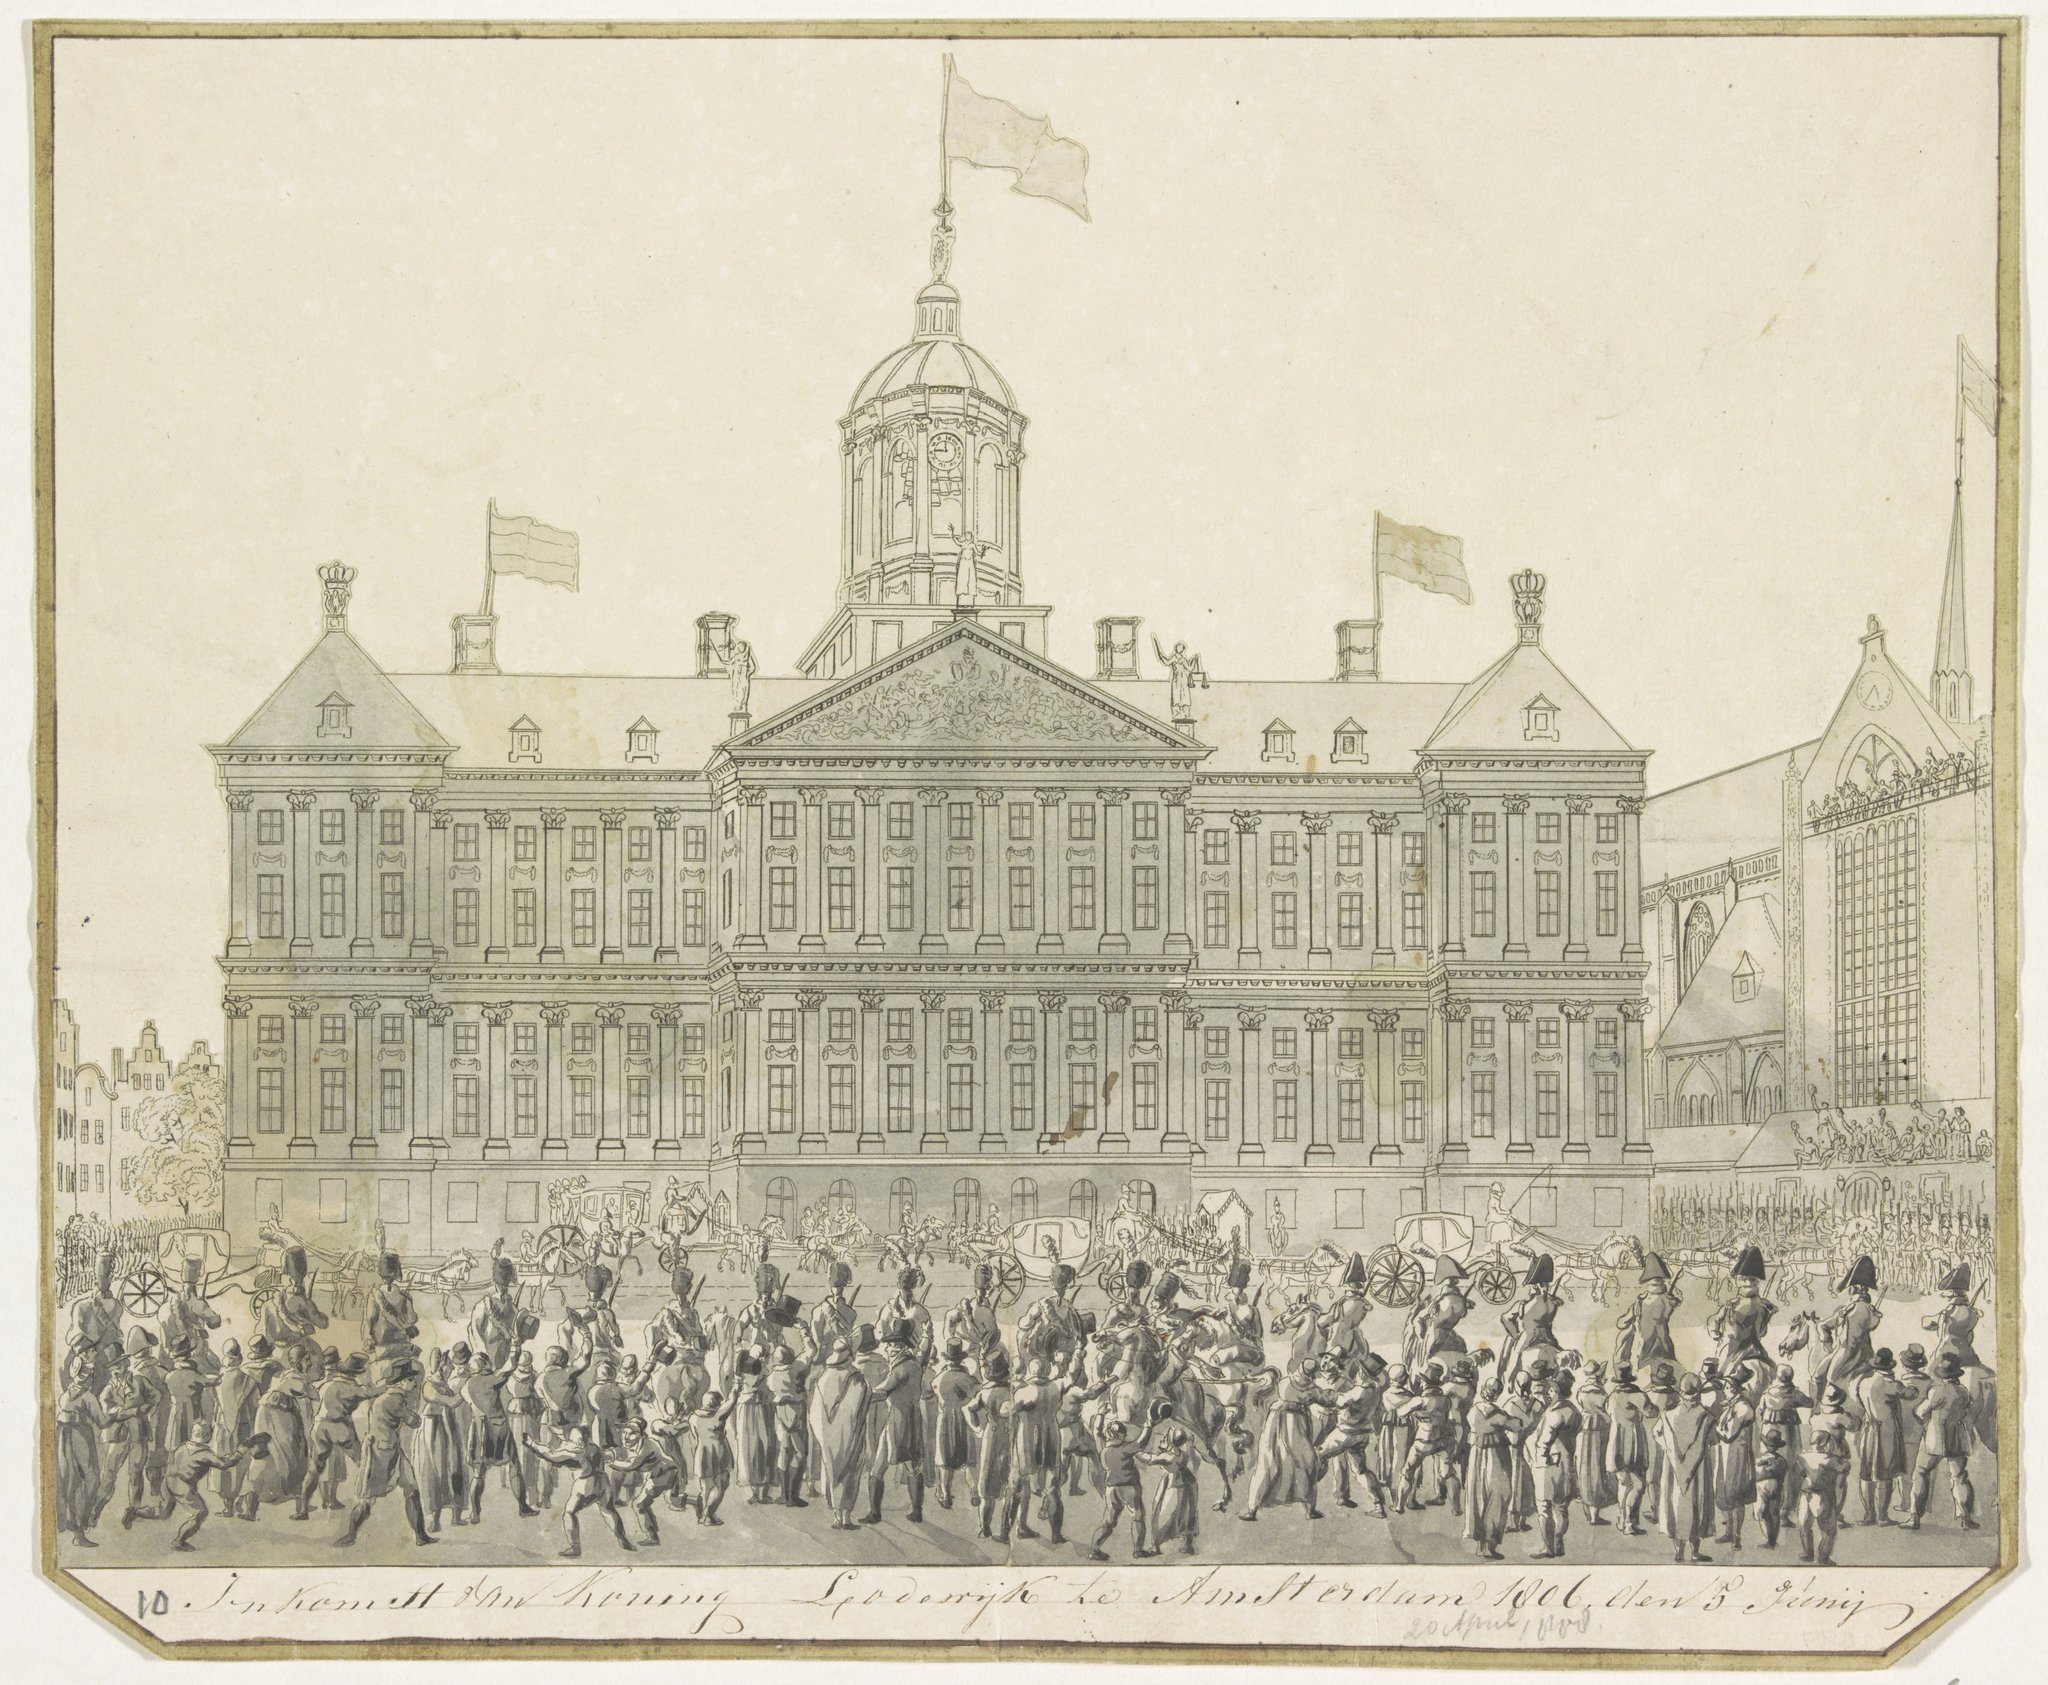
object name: print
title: Inkomst van Koning Lodewijk te Amsterdam 1806, den 5 Junij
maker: Anonymous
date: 1808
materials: paper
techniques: brush, etching, pen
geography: netherlands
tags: louis napoleon (king of holland), public festivities at other royal events, not meant or mentioned above, royal palace of amsterdam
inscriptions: collector's mark: Lugt 2228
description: Feestelijke aankomst van Lodewijk Napoleon als koning van Holland te Amsterdam bij het Paleis op de Dam, 20 april 1808.